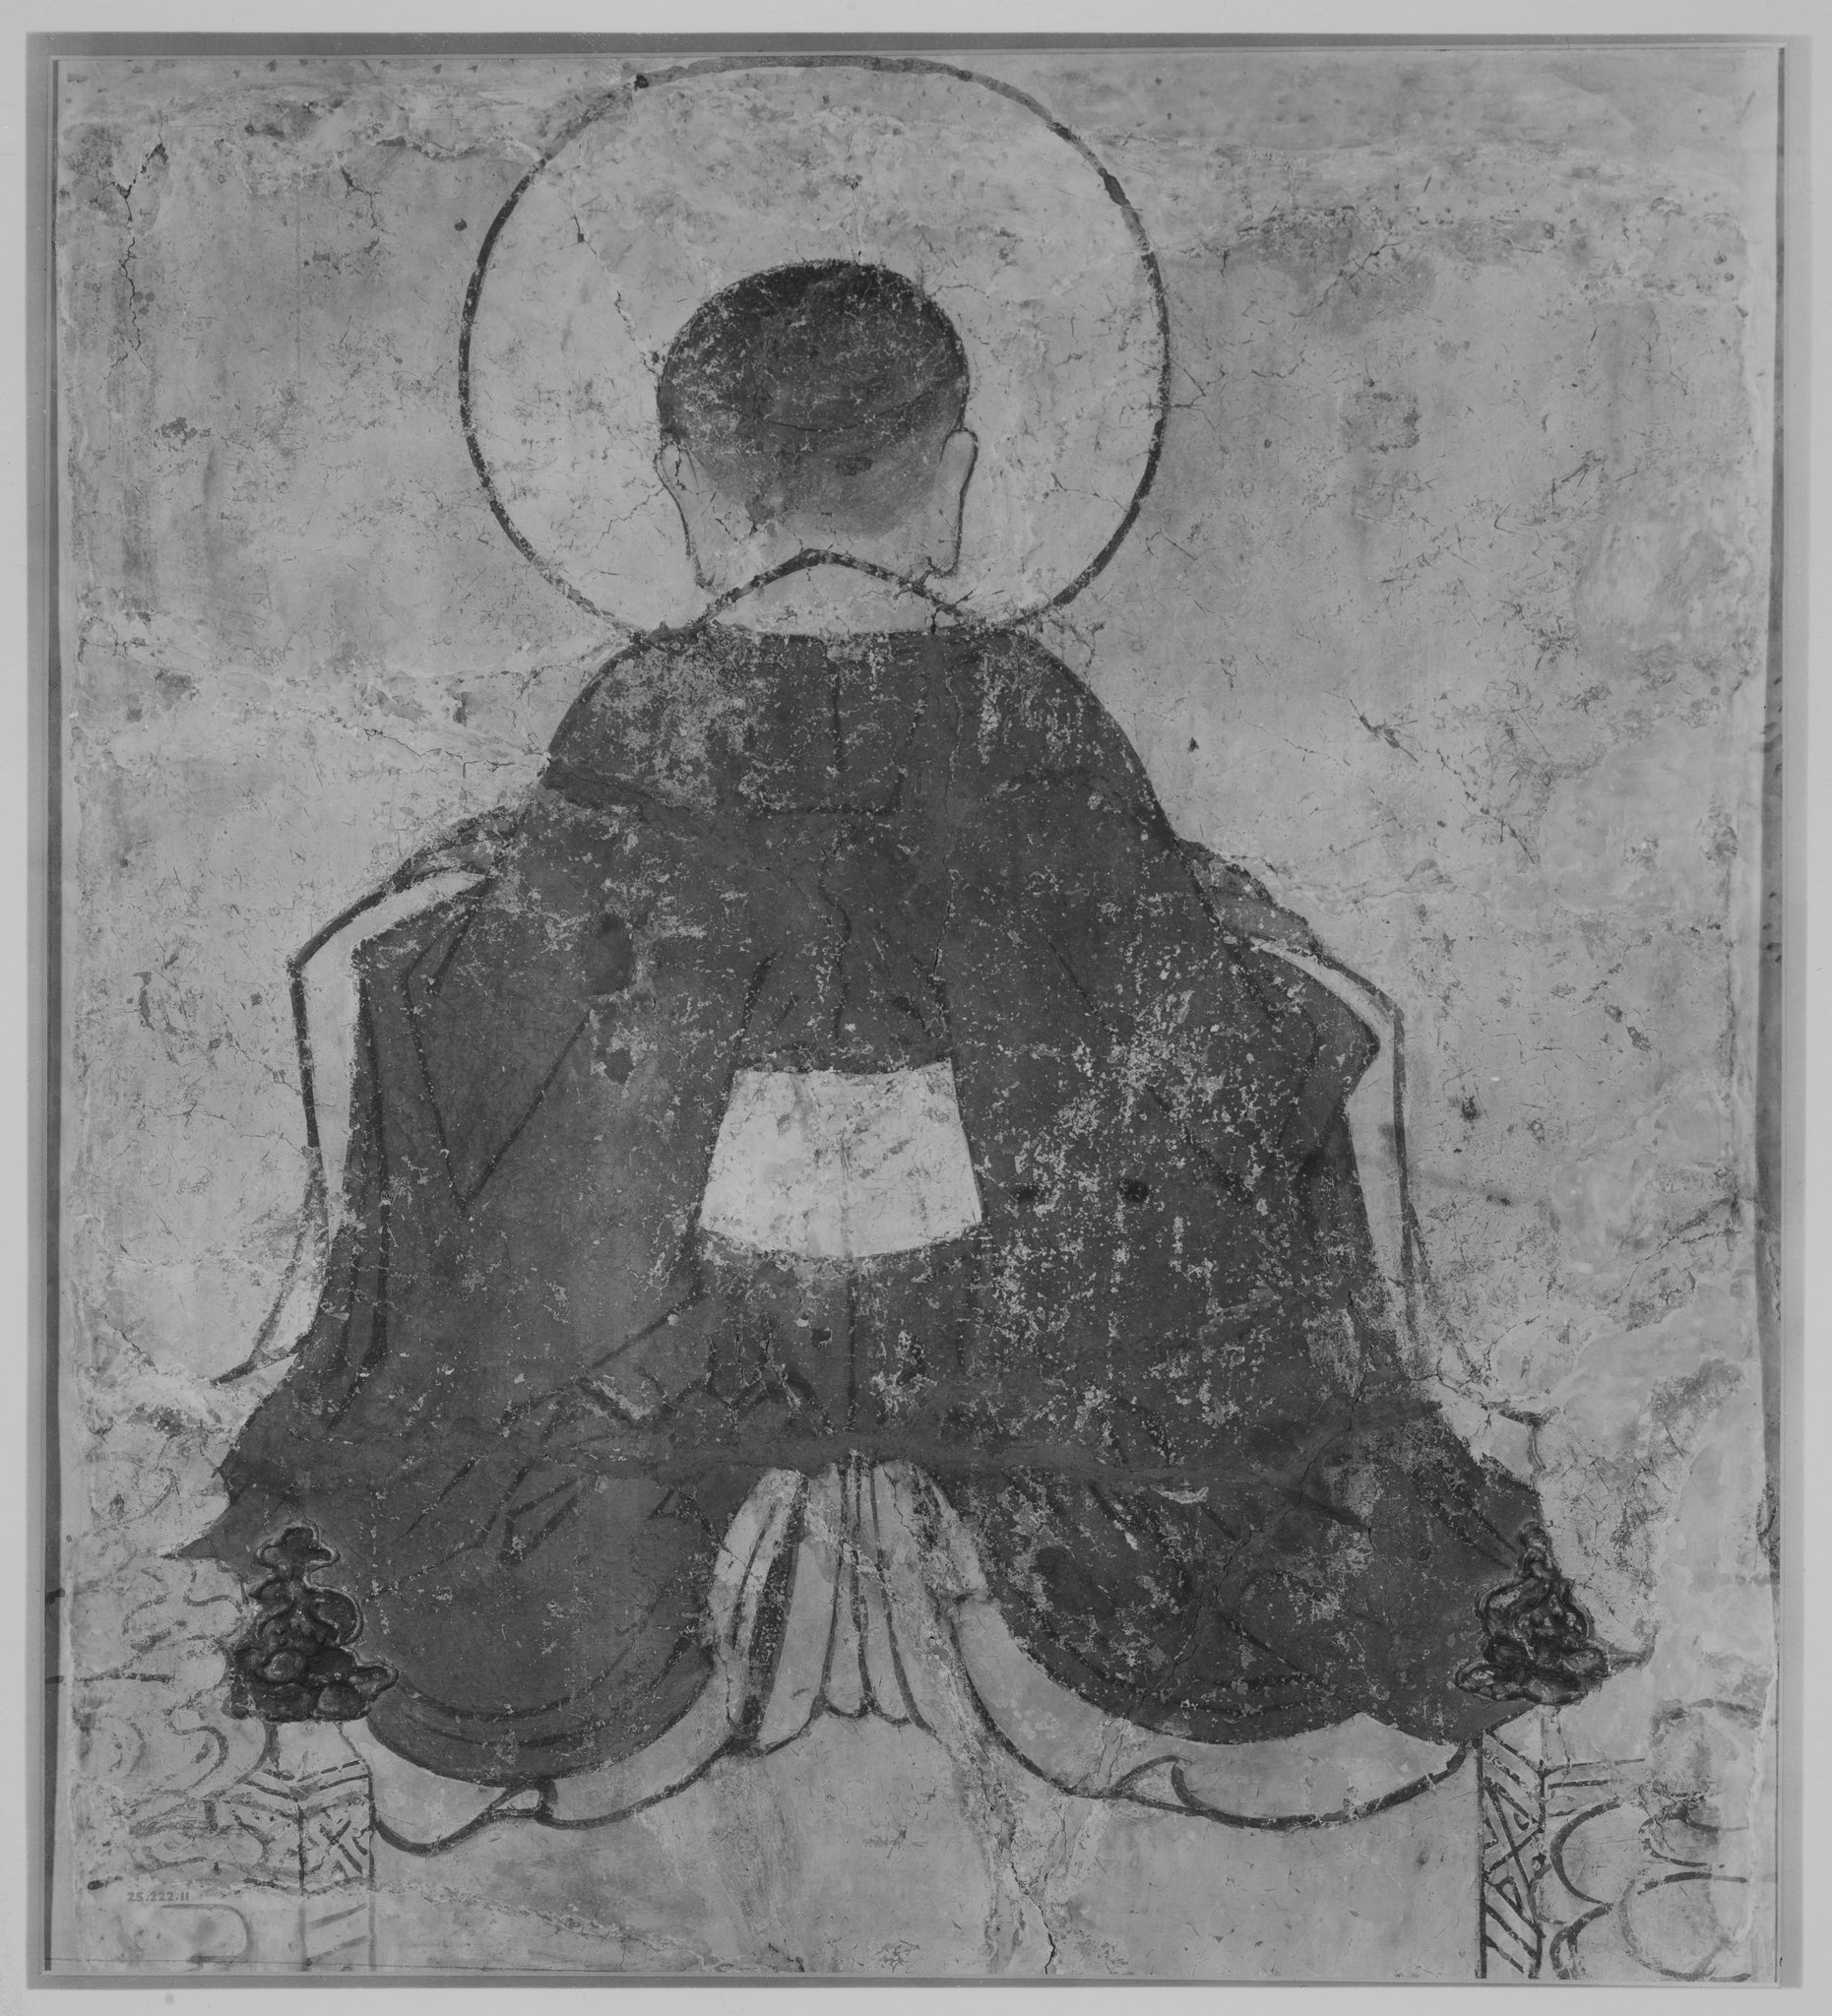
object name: wall painting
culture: chinese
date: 960-1279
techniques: fresco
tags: men